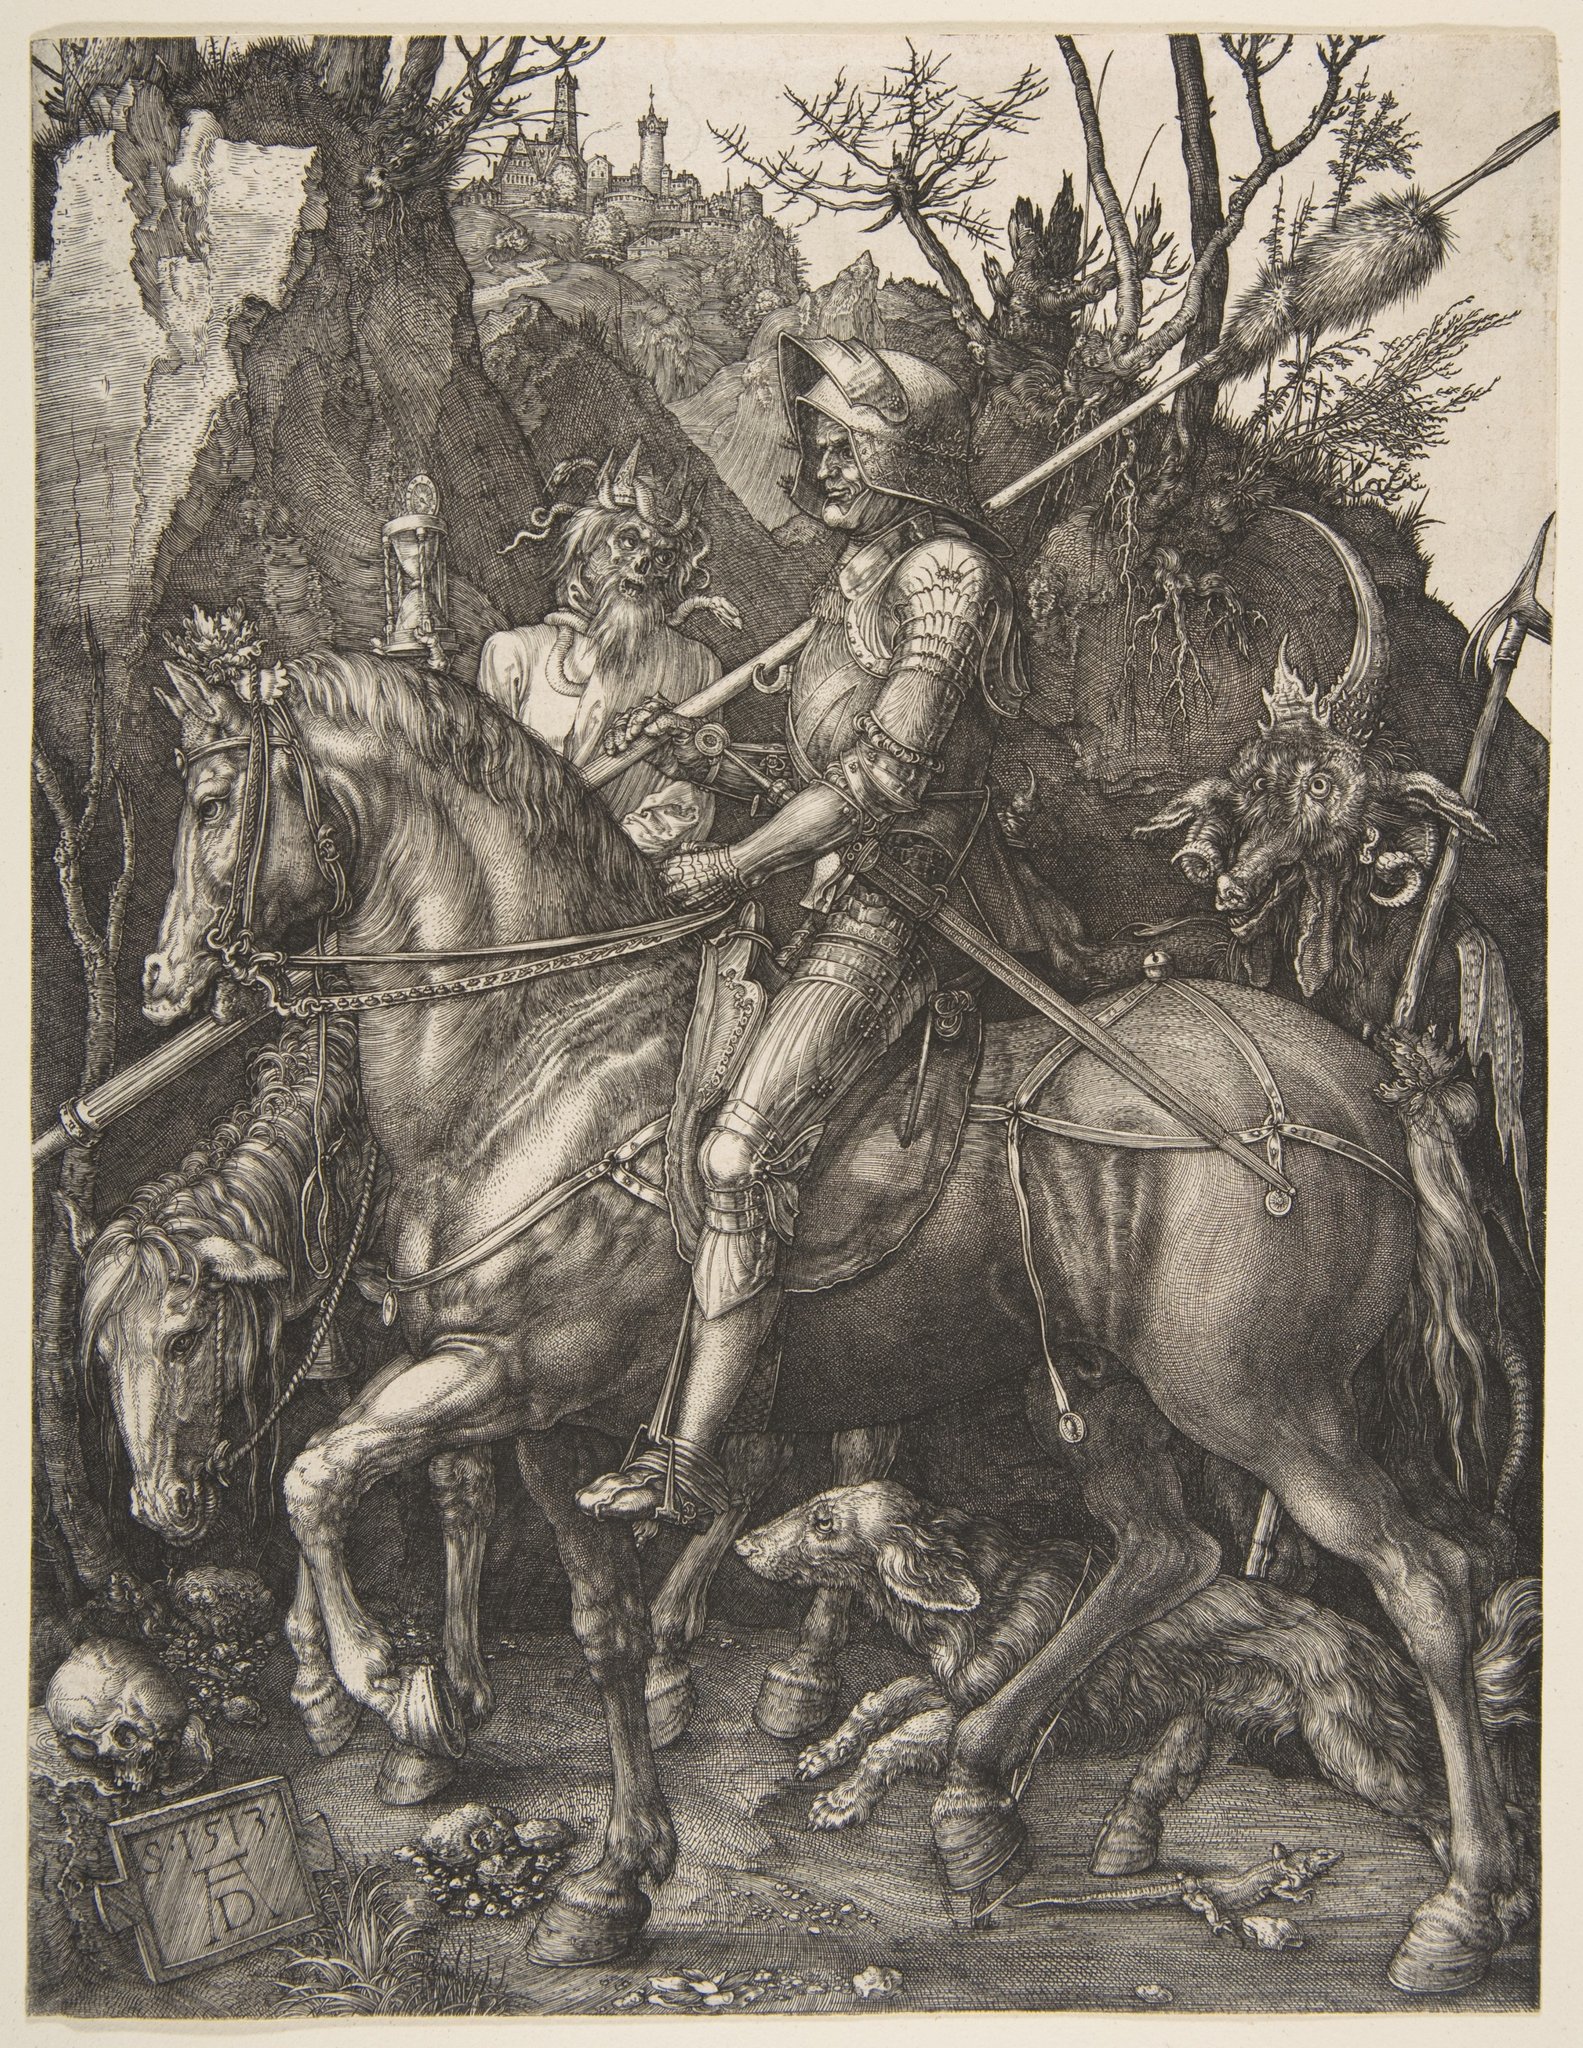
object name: print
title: Knight, Death, and the Devil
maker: albrecht dürer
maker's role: artist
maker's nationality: german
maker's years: 1471-1528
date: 1513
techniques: engraving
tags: armor,weapons,skulls,men,dogs,horses,devil,death,knights